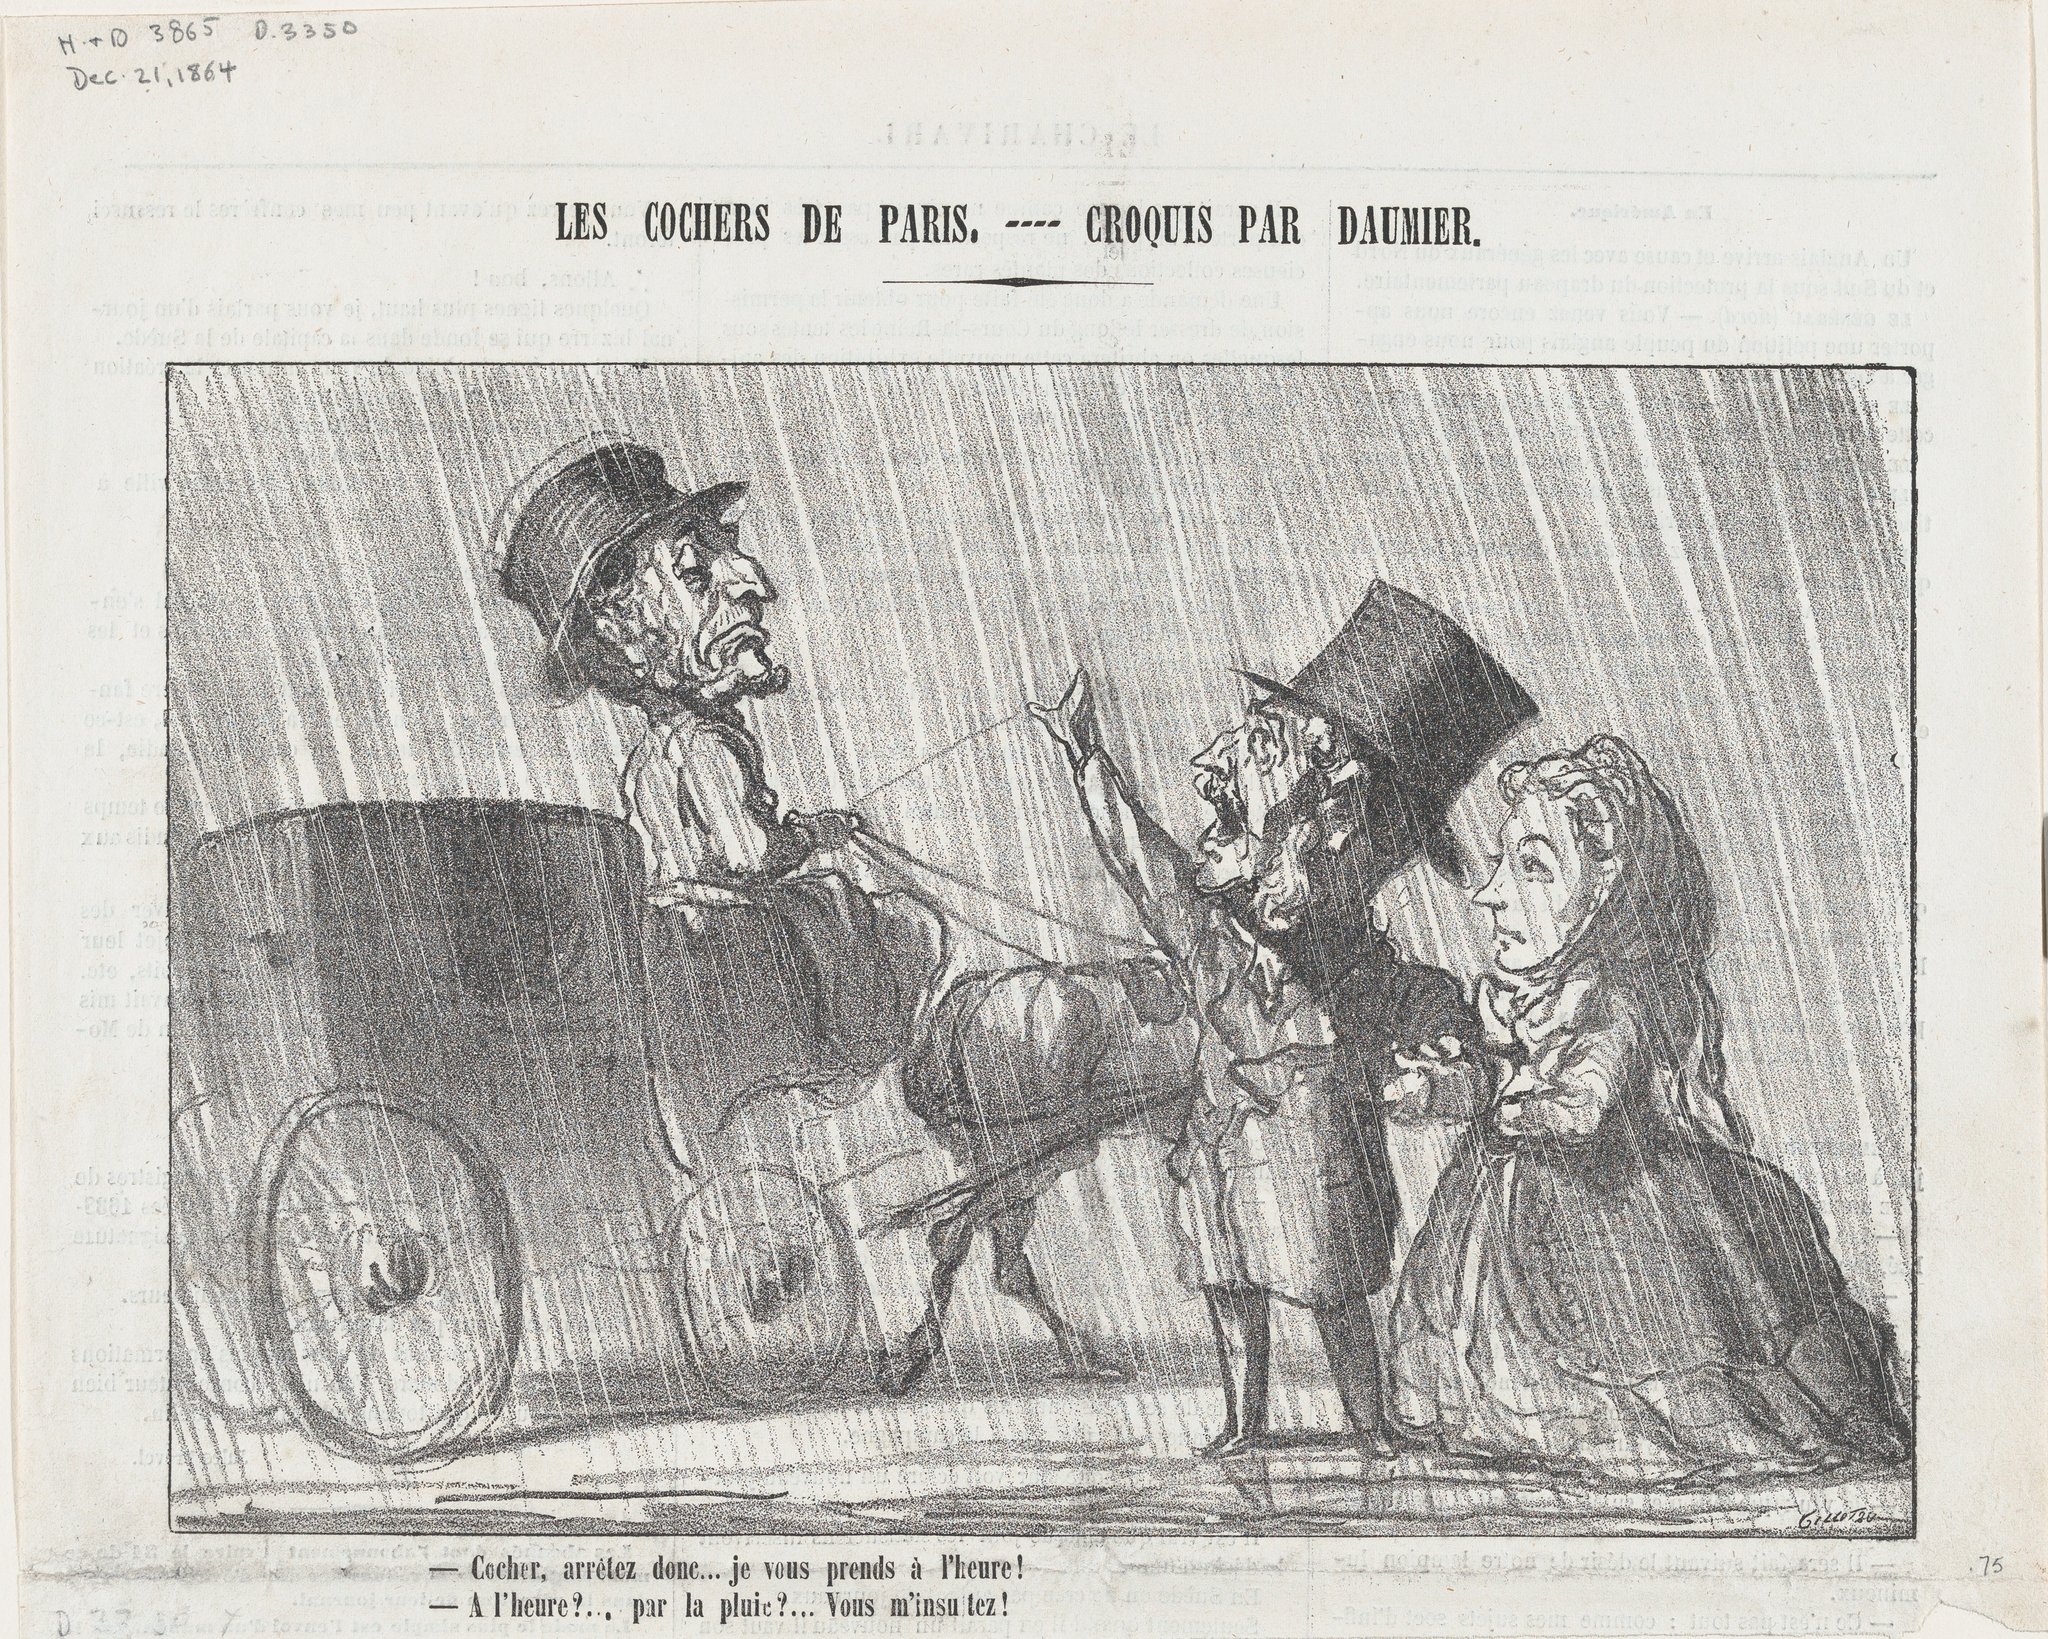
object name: print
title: Driver, Stop, I will hire you and pay you by the hour!, from 'The coachmen in Paris,' published in Le Charivari, December 21, 1864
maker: honoré daumier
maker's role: artist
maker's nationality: french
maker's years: 1808-1879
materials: paper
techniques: lithograph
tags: men,women,carriages